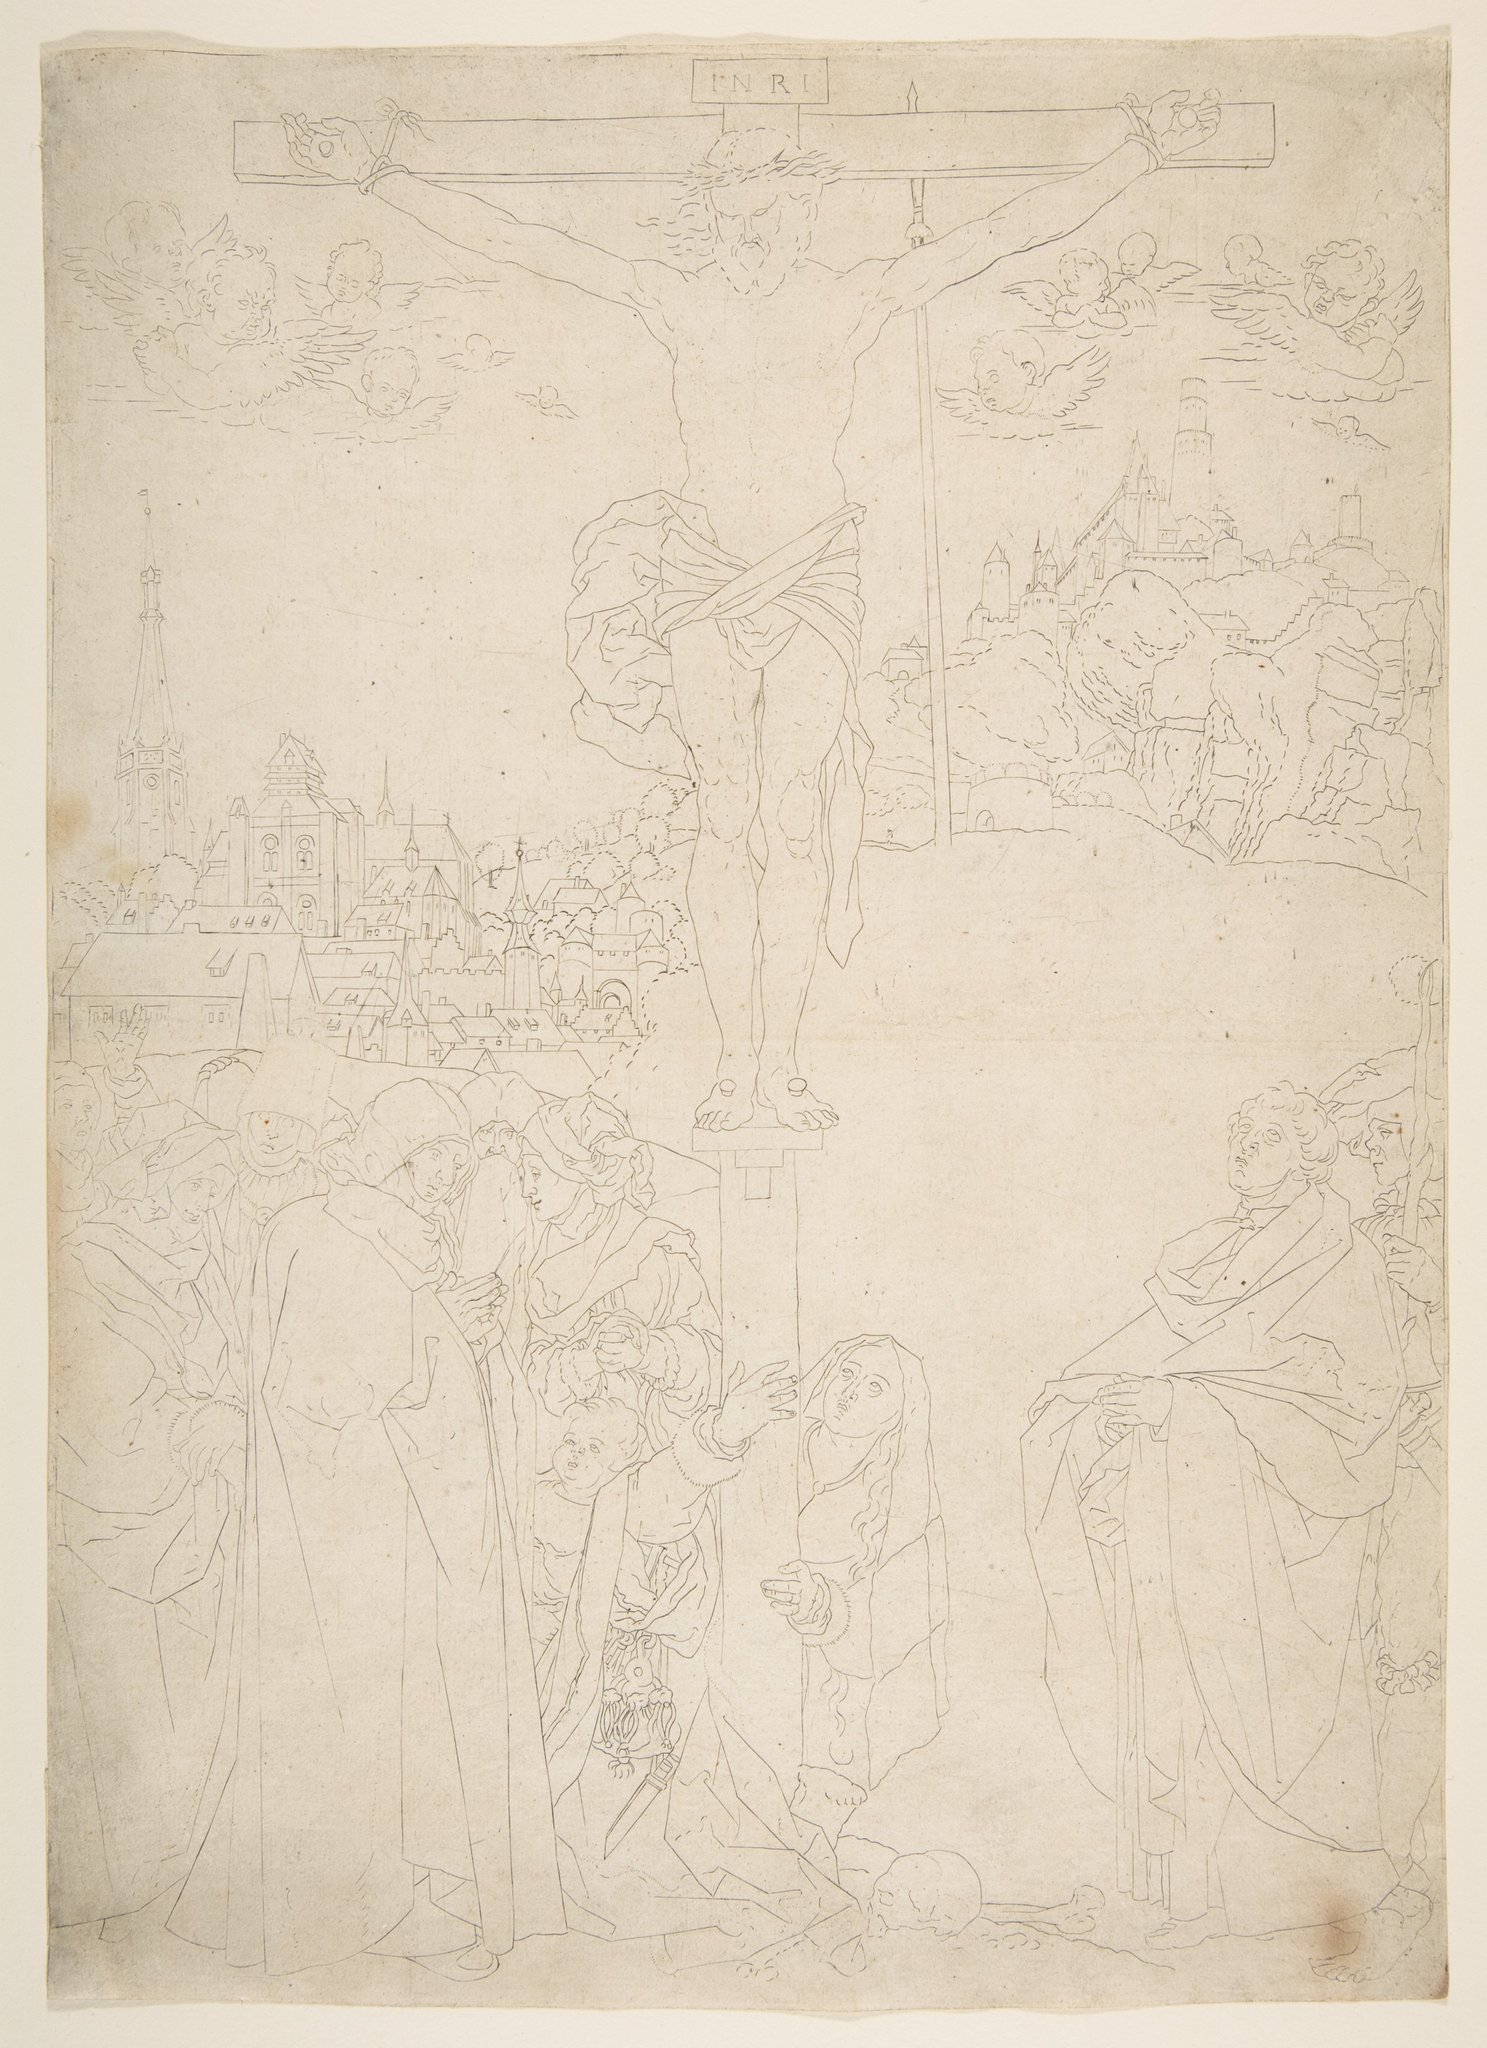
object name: print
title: The Crucifixion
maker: albrecht dürer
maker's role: artist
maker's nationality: german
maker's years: 1471-1528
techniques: engraving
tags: men,women,crucifixion